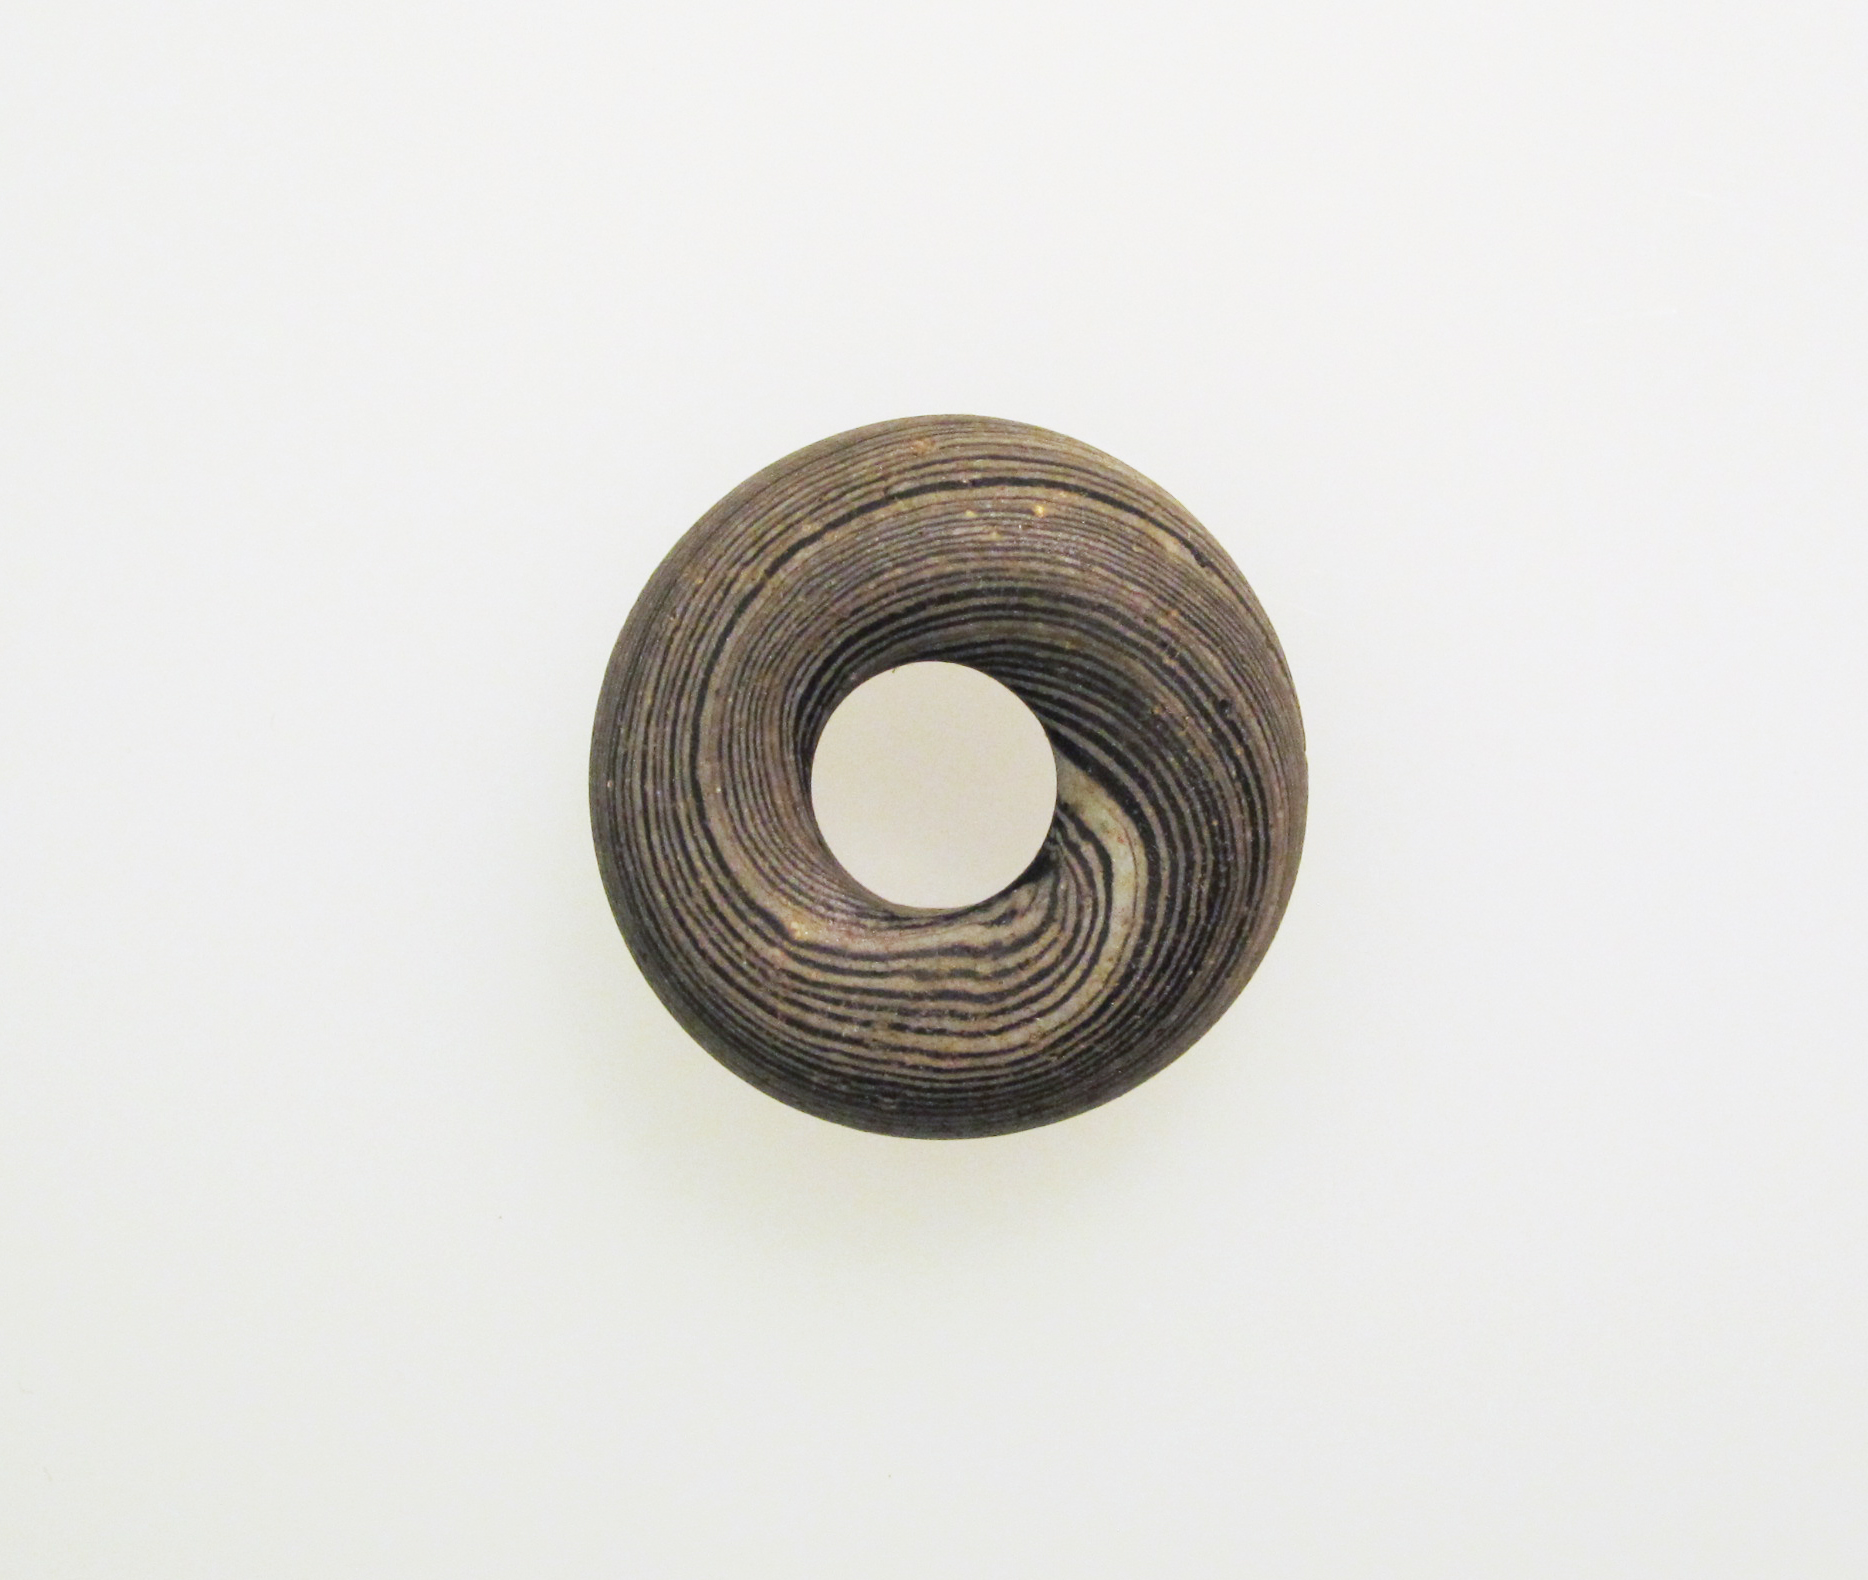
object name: bead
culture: roman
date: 670 BCE-330 CE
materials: glass